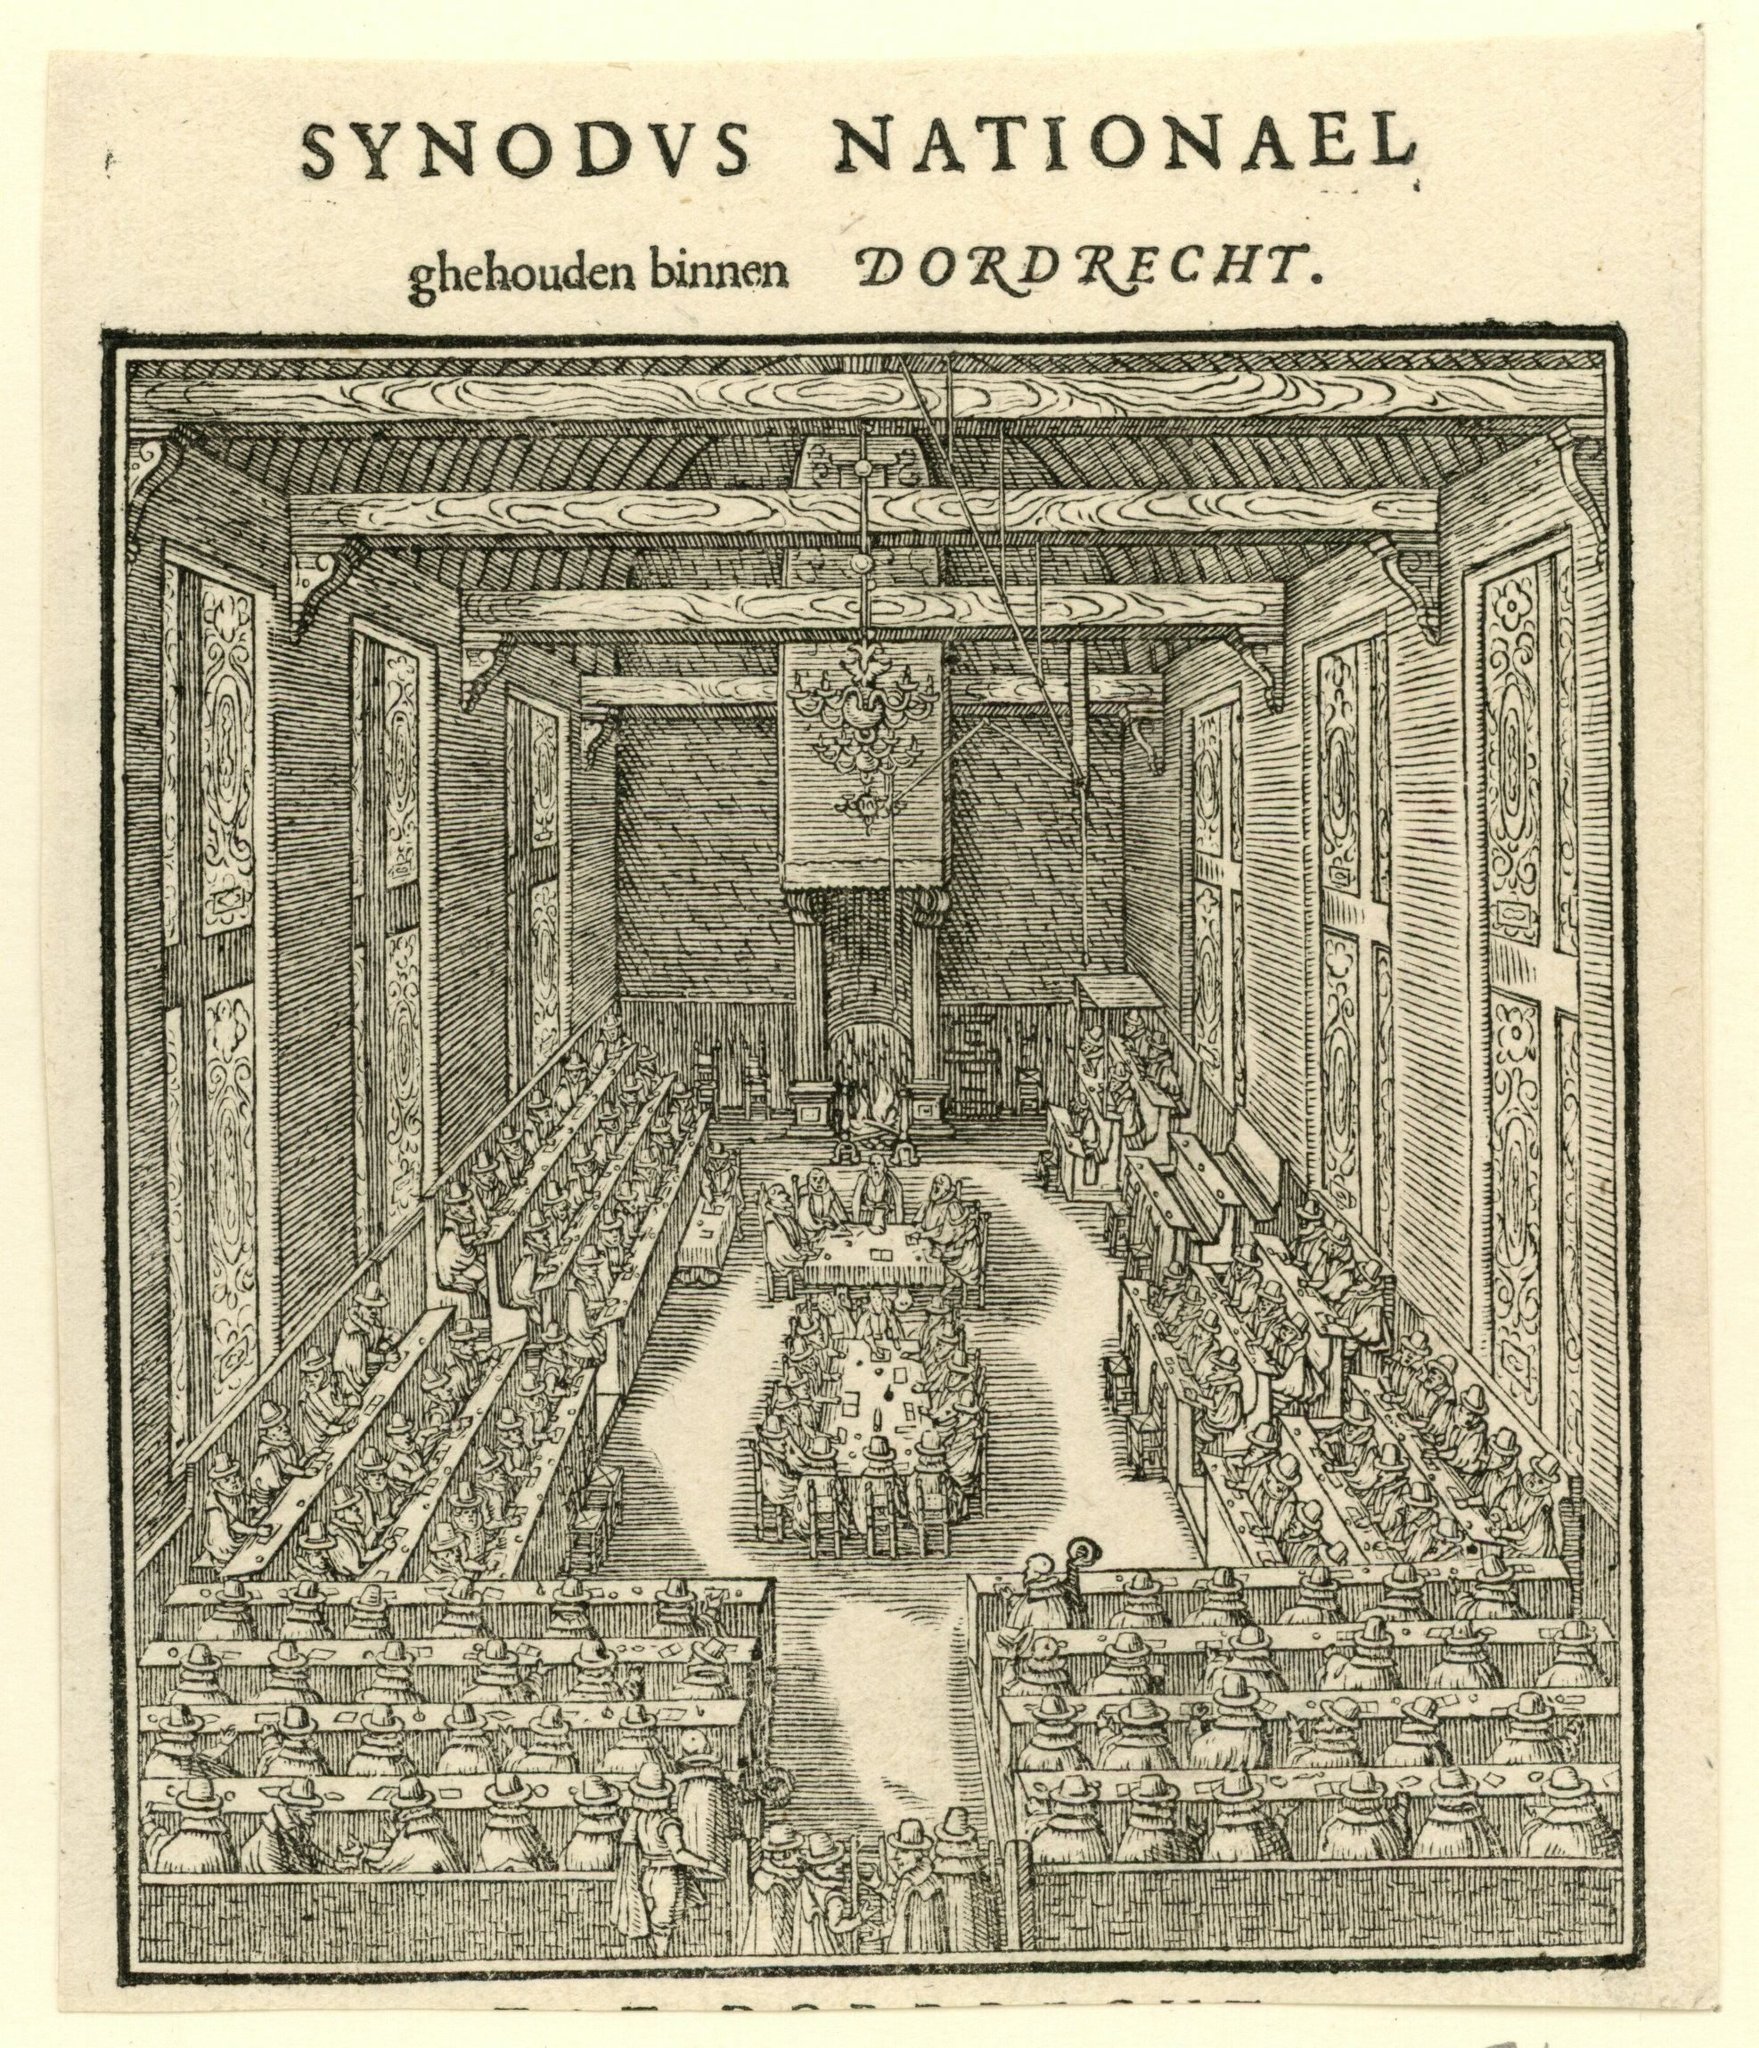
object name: print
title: Synodvs Nationael ghehouden binnen Dordrecht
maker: Anonymous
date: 1618-1619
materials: paper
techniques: letterpress printing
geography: northern netherlands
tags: organizations, assemblies, etc. in protestant churches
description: De opening van de nationale synode te Dordrecht op 13 november 1618. Interieur van de grote zaal in de Kloveniersdoelen met alle aanwezigen en toeschouwers. Waarschijnlijk gebruikt als titelprent bij een pamflet.